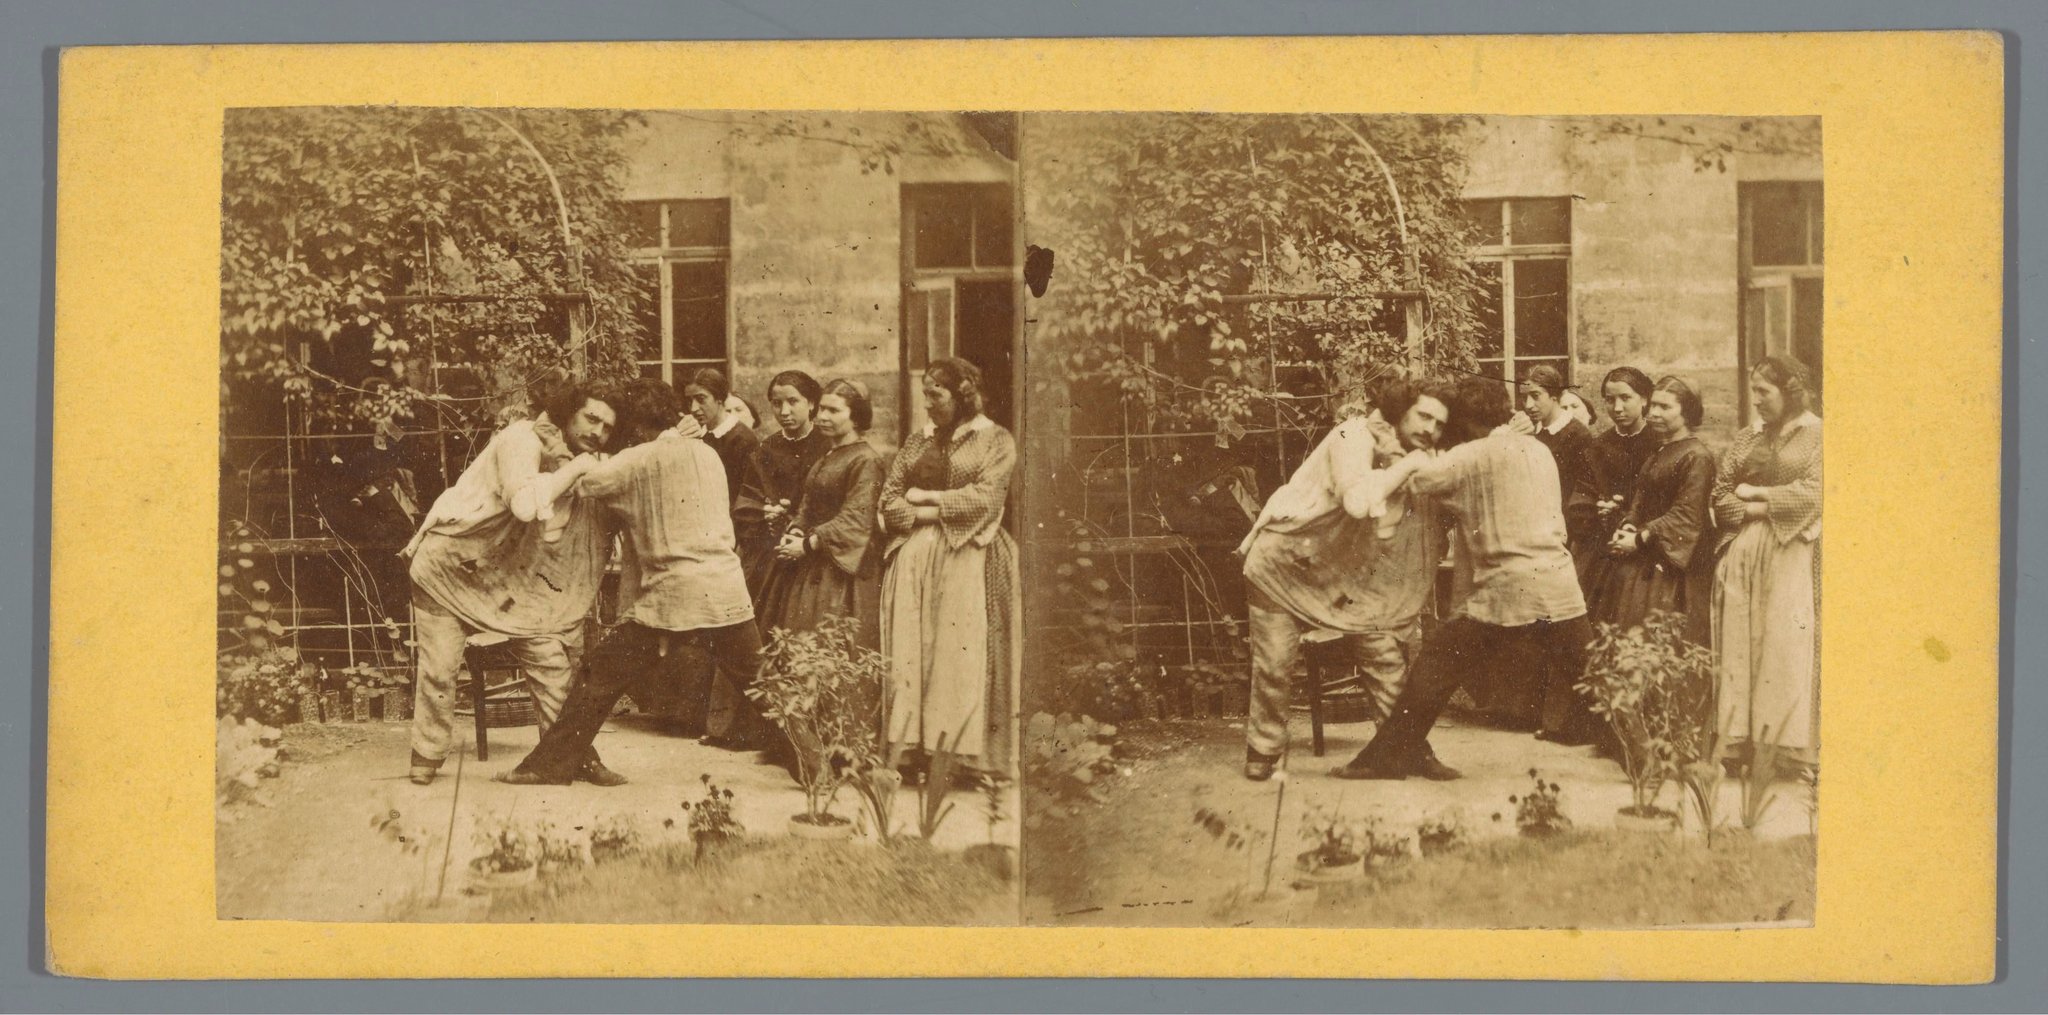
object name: stereograph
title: Vrouwen kijken naar twee vechtende mannen in een tuin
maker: Anonymous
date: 1850-1880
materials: cardboard, photographic support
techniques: albumen print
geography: europe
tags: garden, battle, fighting in general, europe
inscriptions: number: ‘6 20’